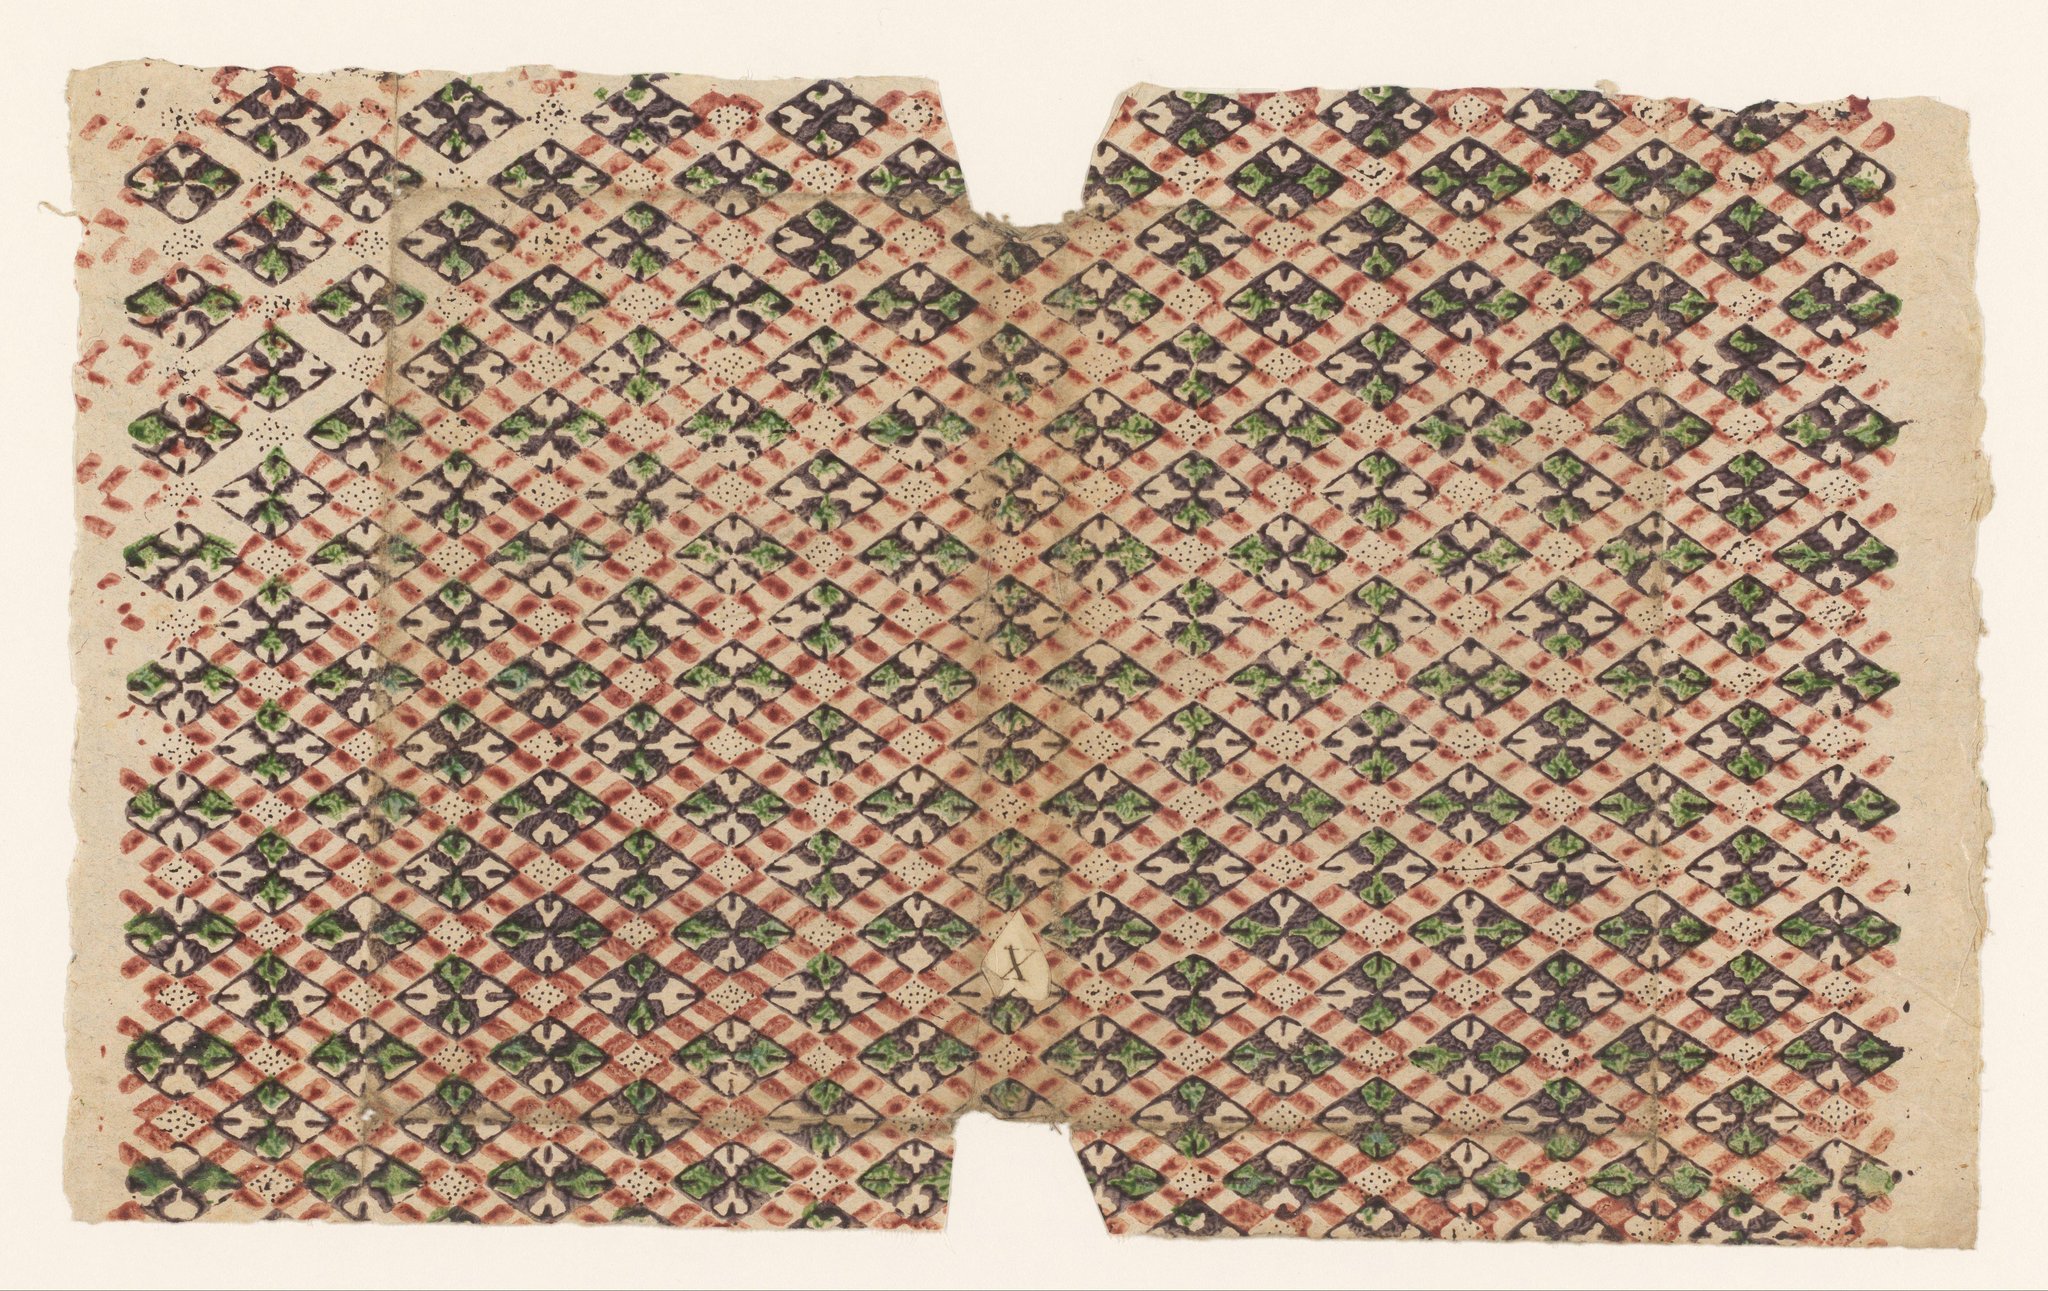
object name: printed paper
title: Blad met ruitenpatroon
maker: Anonymous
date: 1750-1900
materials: paper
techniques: printing block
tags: ornament derived from plant forms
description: Blad met ruitenpatroon van bladmotief tussen strepen en punten. Gebruikt als omslag, met etiket op de rug.